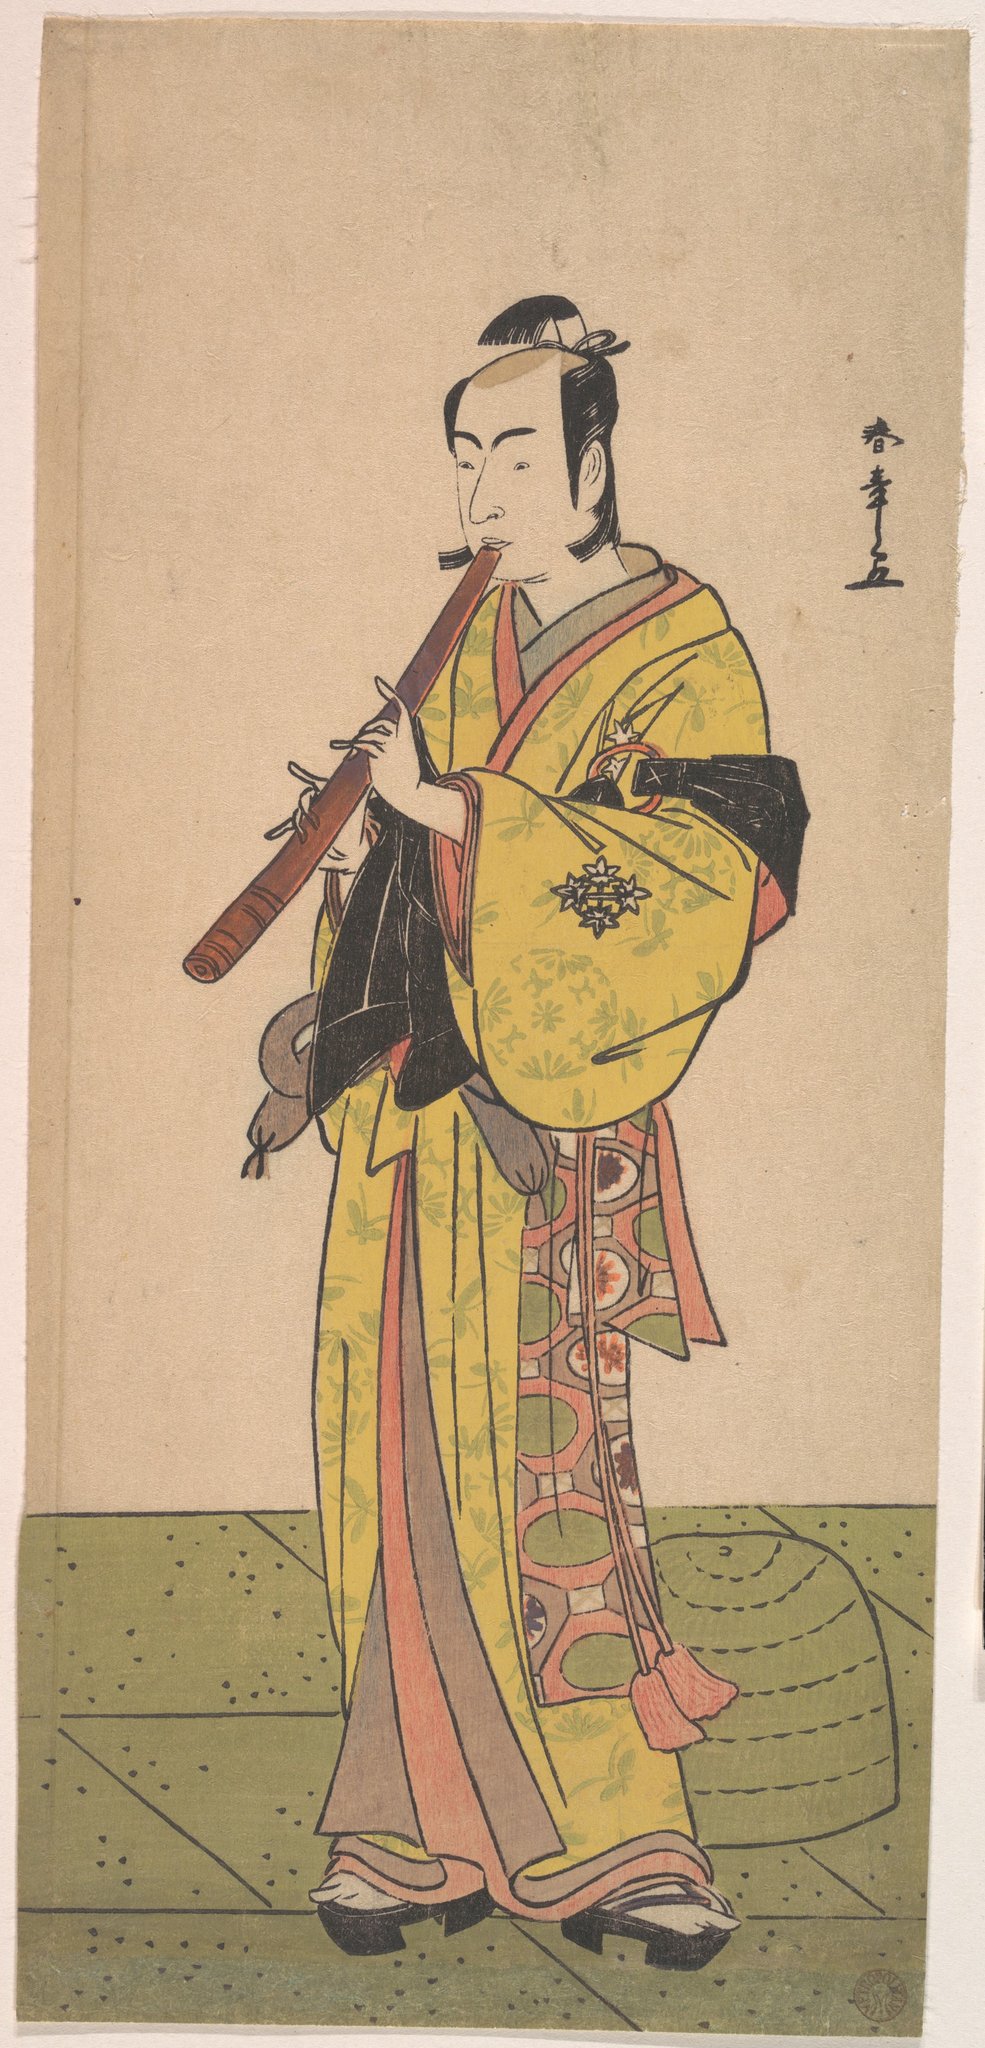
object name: woodblock print nishiki e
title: Ichikawa Bennosuke as a Man in Komuso Attire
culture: japanese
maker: katsukawa shunshō 勝川春章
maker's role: artist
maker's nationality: japanese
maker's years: 1726-1792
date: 1788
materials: ink, paper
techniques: nishiki e, woodblock print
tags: musical instruments,men,actors